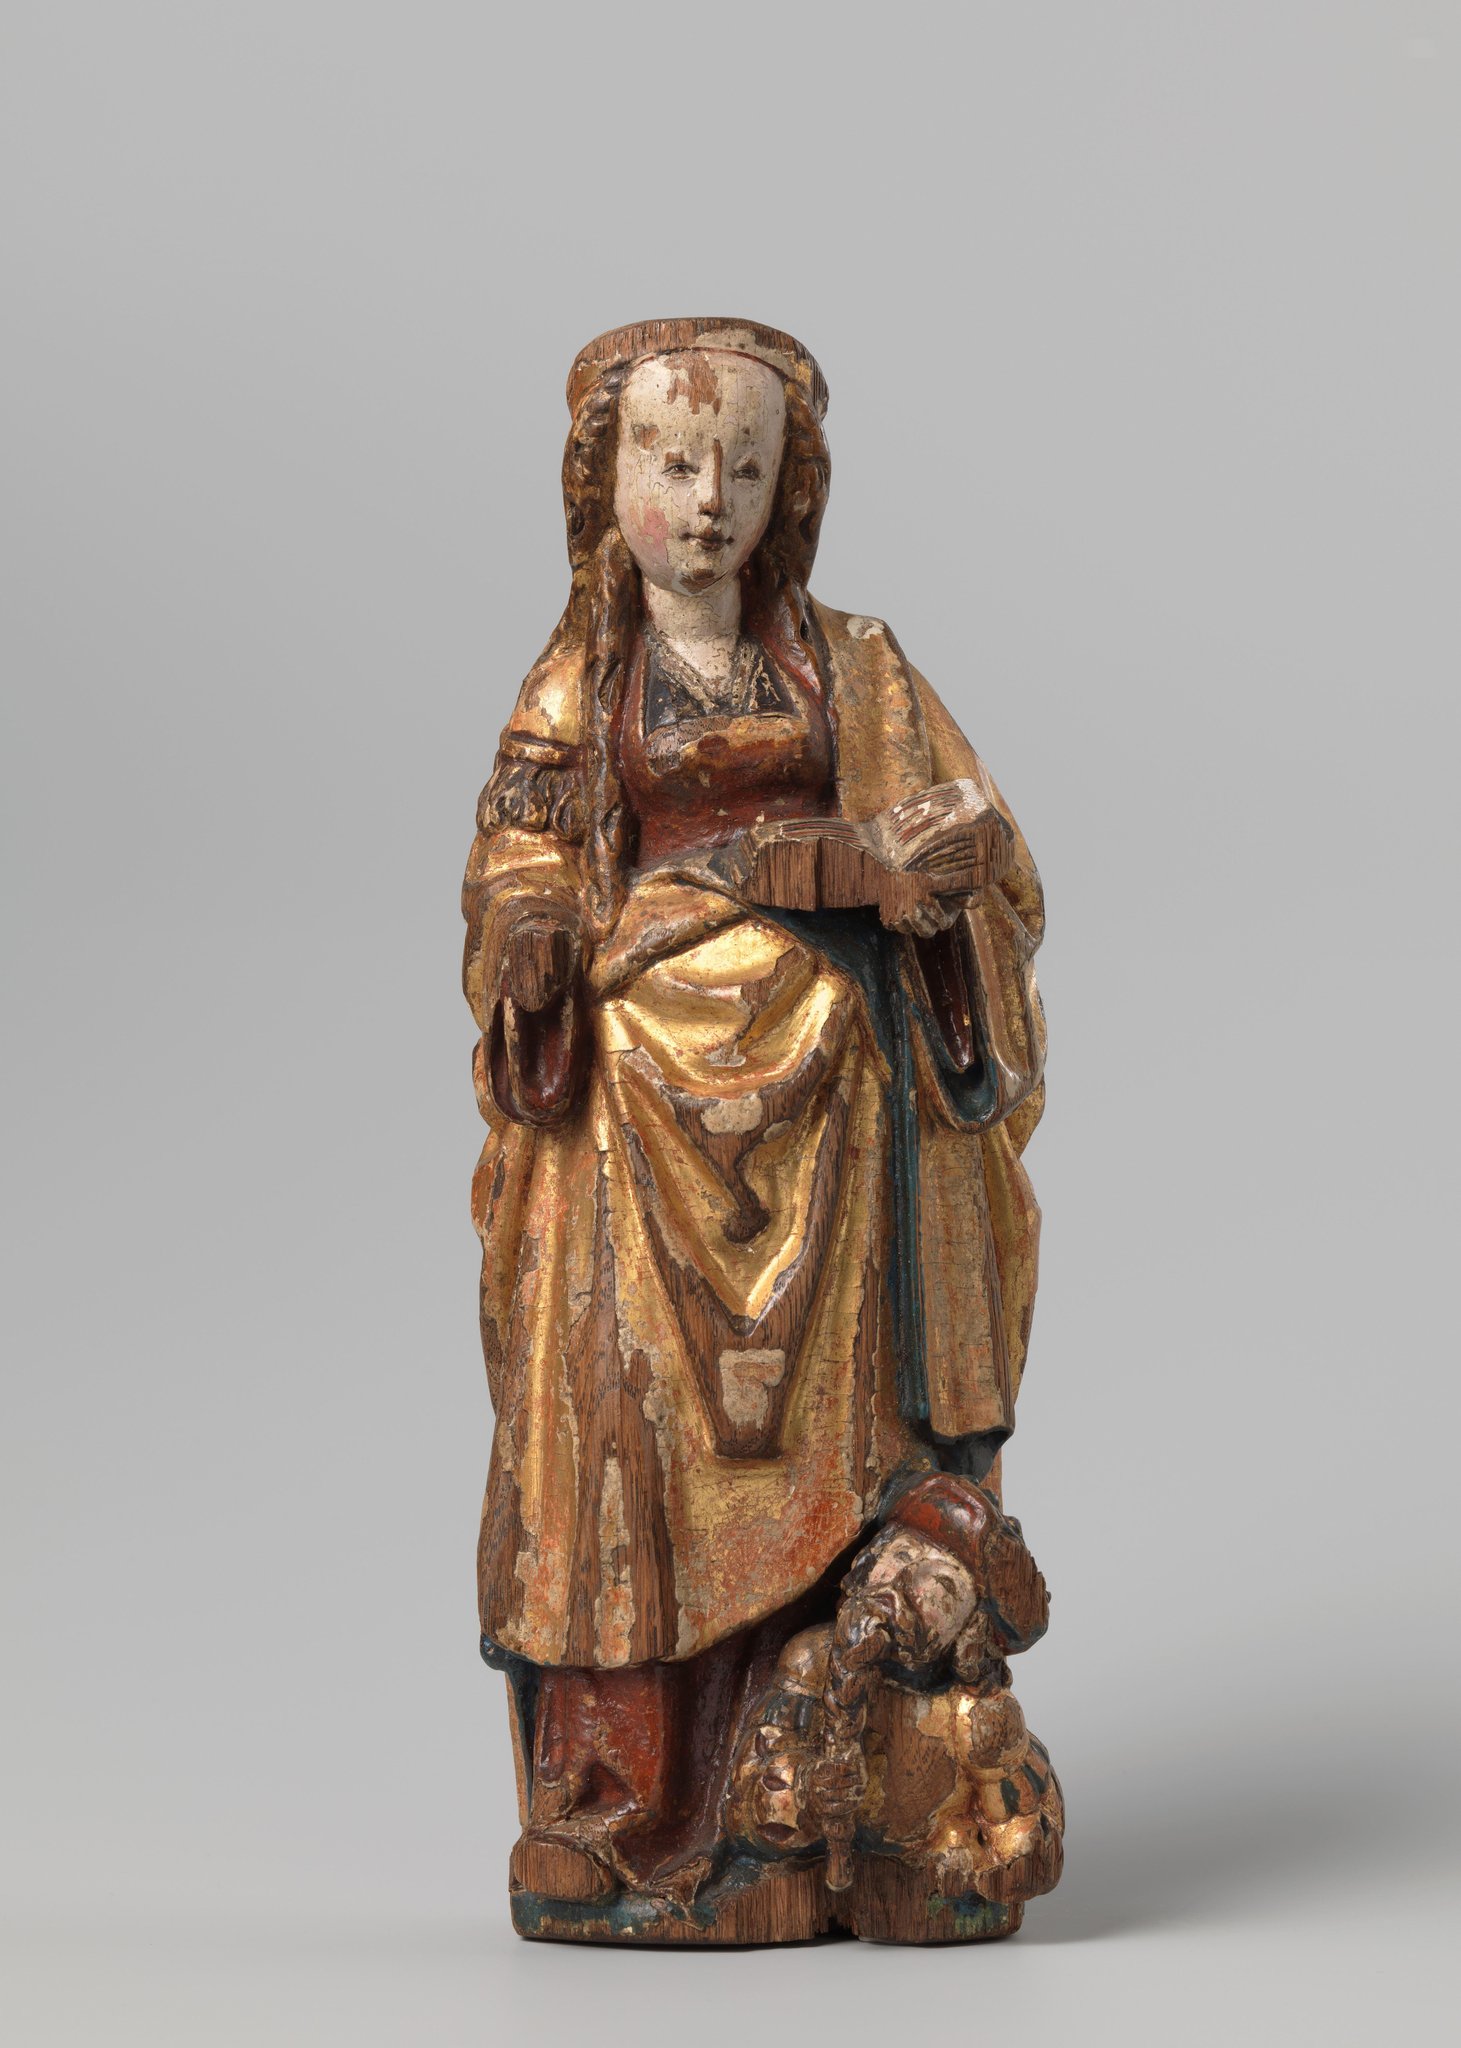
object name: sculpture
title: St Catherine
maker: Anonymous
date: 1500-1510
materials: wood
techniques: polychromy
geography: mechelen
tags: the virgin martyr catherine of alexandria; possible attributes: book, crown, emperor maxentius, palm-branch, ring, sword, wheel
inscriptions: mark, on the reverse, branded: three vertical pales (the Mechelen wood quality mark)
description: Zij staat op een grondje met het naar voren gebogen rechterbeen over de liggende Maxentius heen. In de linkerhand draagt zij een opengeslagen boek. Haar bovenlichaam met afhangende rechterarm buigt iets naar links door. De haren vallen over rug en schouders. Over een hemd en onderkleed, beide met v-vormige halsuitsnijding, een gewaad met rechthoekige halsuitsnijding en franje aan de bovenmouw. Van haar linkerschouder loopt de mantel onder de rechterarm door en is naar rechts toegeslagen. Maxentius met lange, gevlochten baard houdt deze met de rechterhand vast, terwijl hij met de linkerarm op het grondje steunt. Hij draagt een kroon en een kostuum, waarvan de mouwen bovenaan afhangende lobben en verder splitten vertonen.